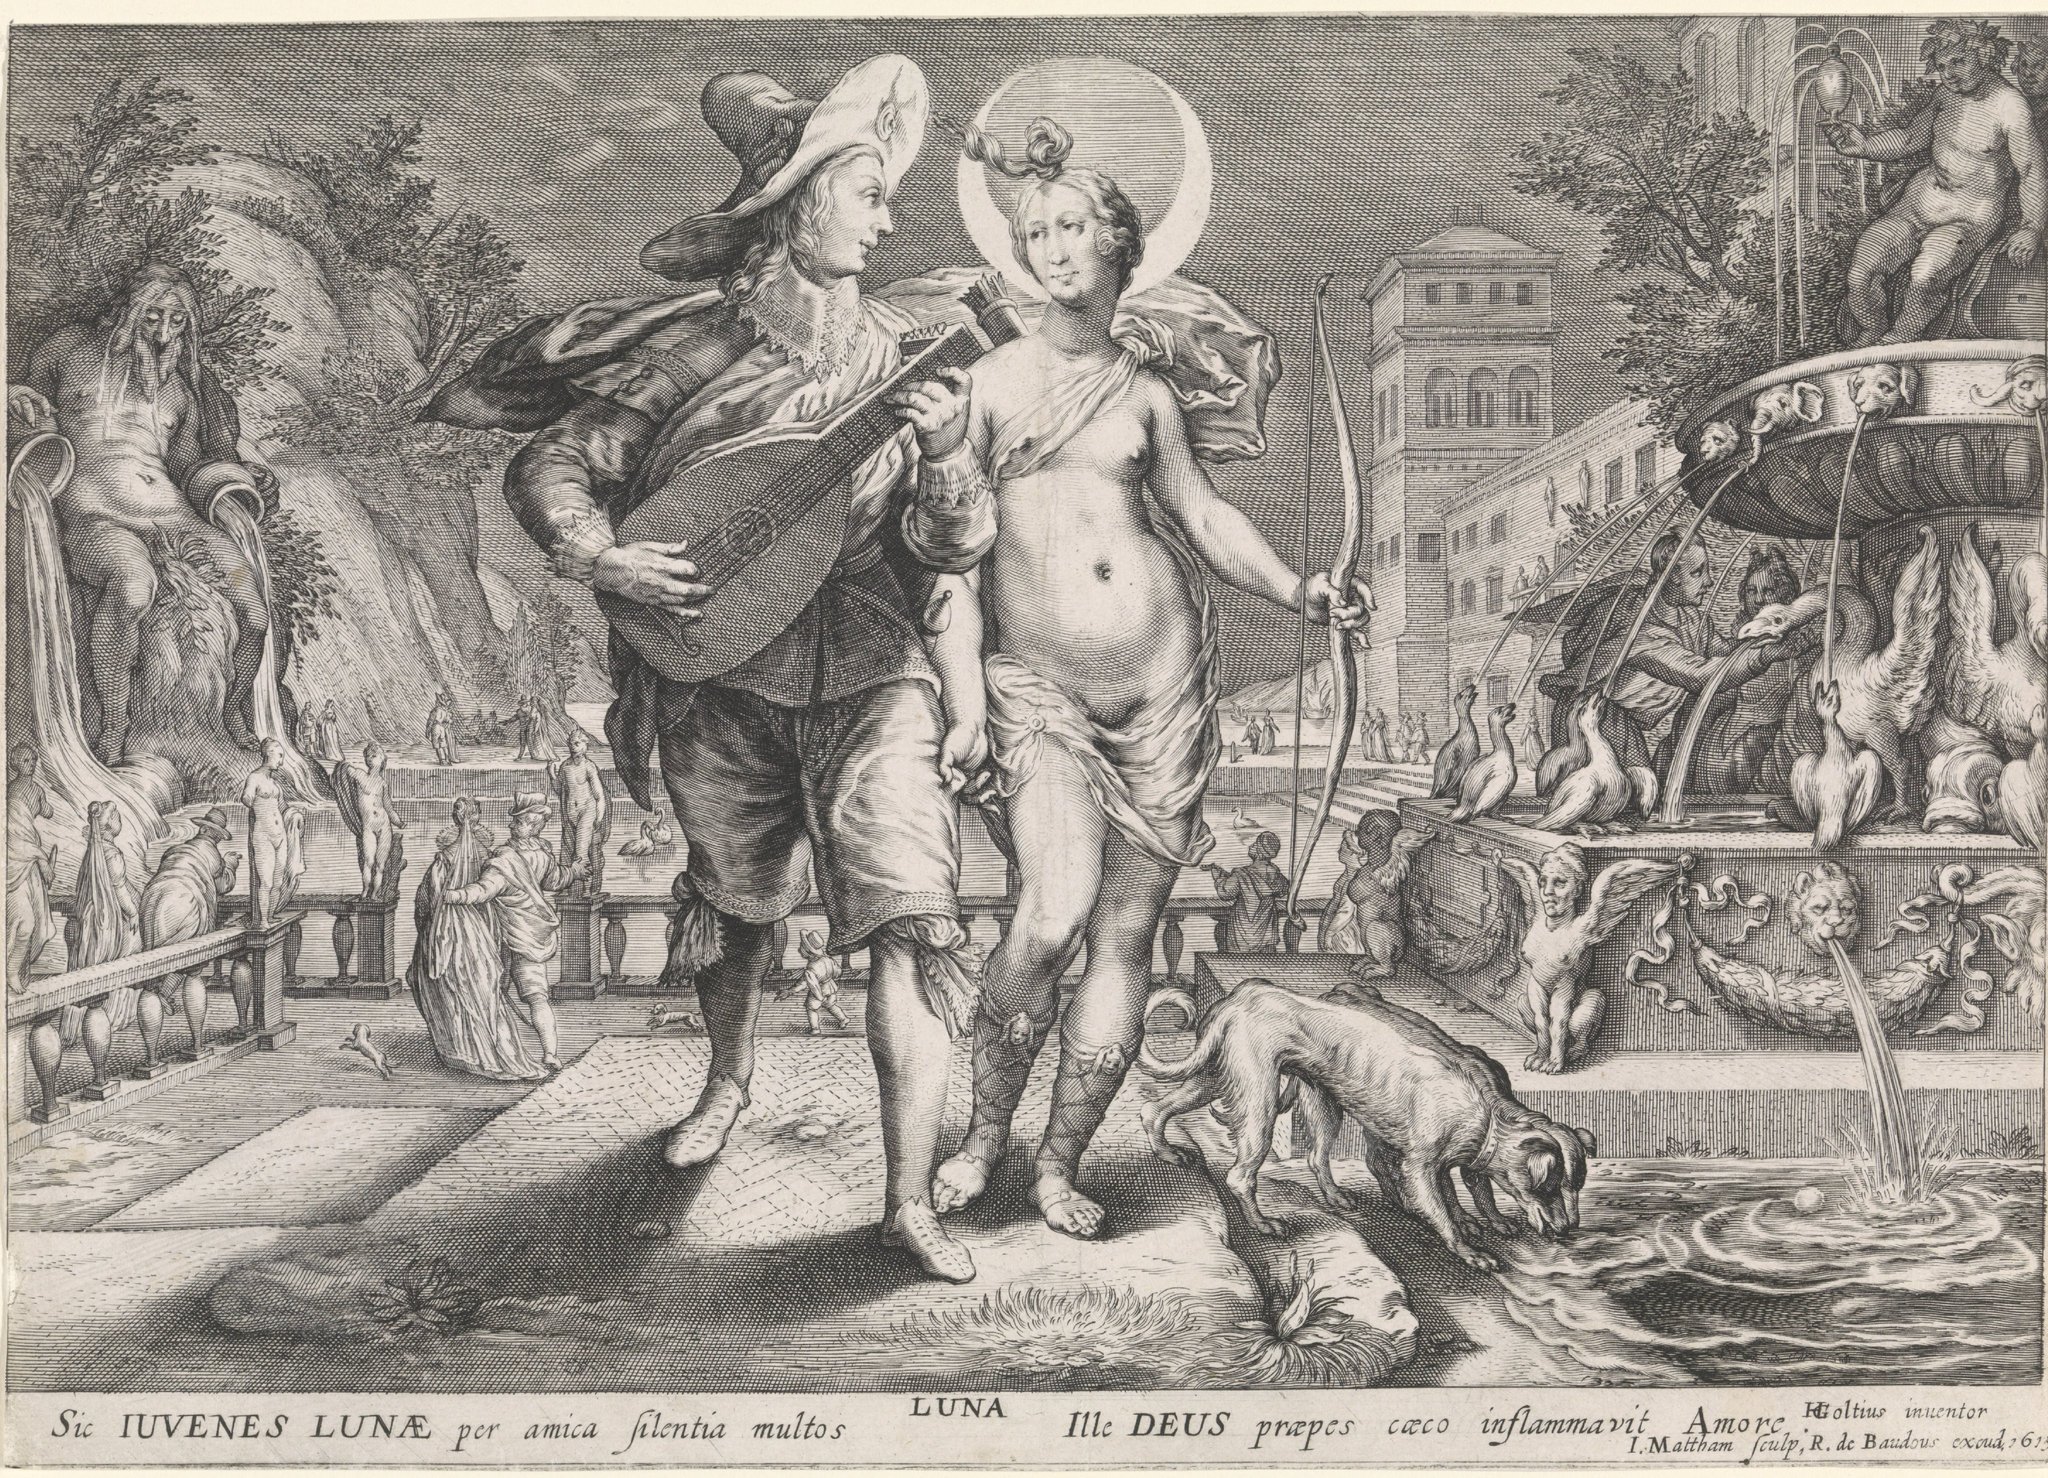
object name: print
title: Luna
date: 1615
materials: paper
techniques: engraving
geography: amsterdam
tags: diana as moon-goddess, i.e. luna (selene), garden fountain, one person playing string instrument (plucked), lute, and special forms of lute, e.g.: theorbo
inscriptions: collector's mark: Lugt 240, caption: ‘Sic Juvenes Lunae...’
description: Diana als de maangodin Luna, met naast haar een jonge man met luit. Zij heeft de stof van zijn broek vast. Zij wandelen in een tuin met rechts een grote fontein. Op de achtergrond wandelen vele figuren bij een vijver van een paleis. Op de voorgrond drinken twee honden.